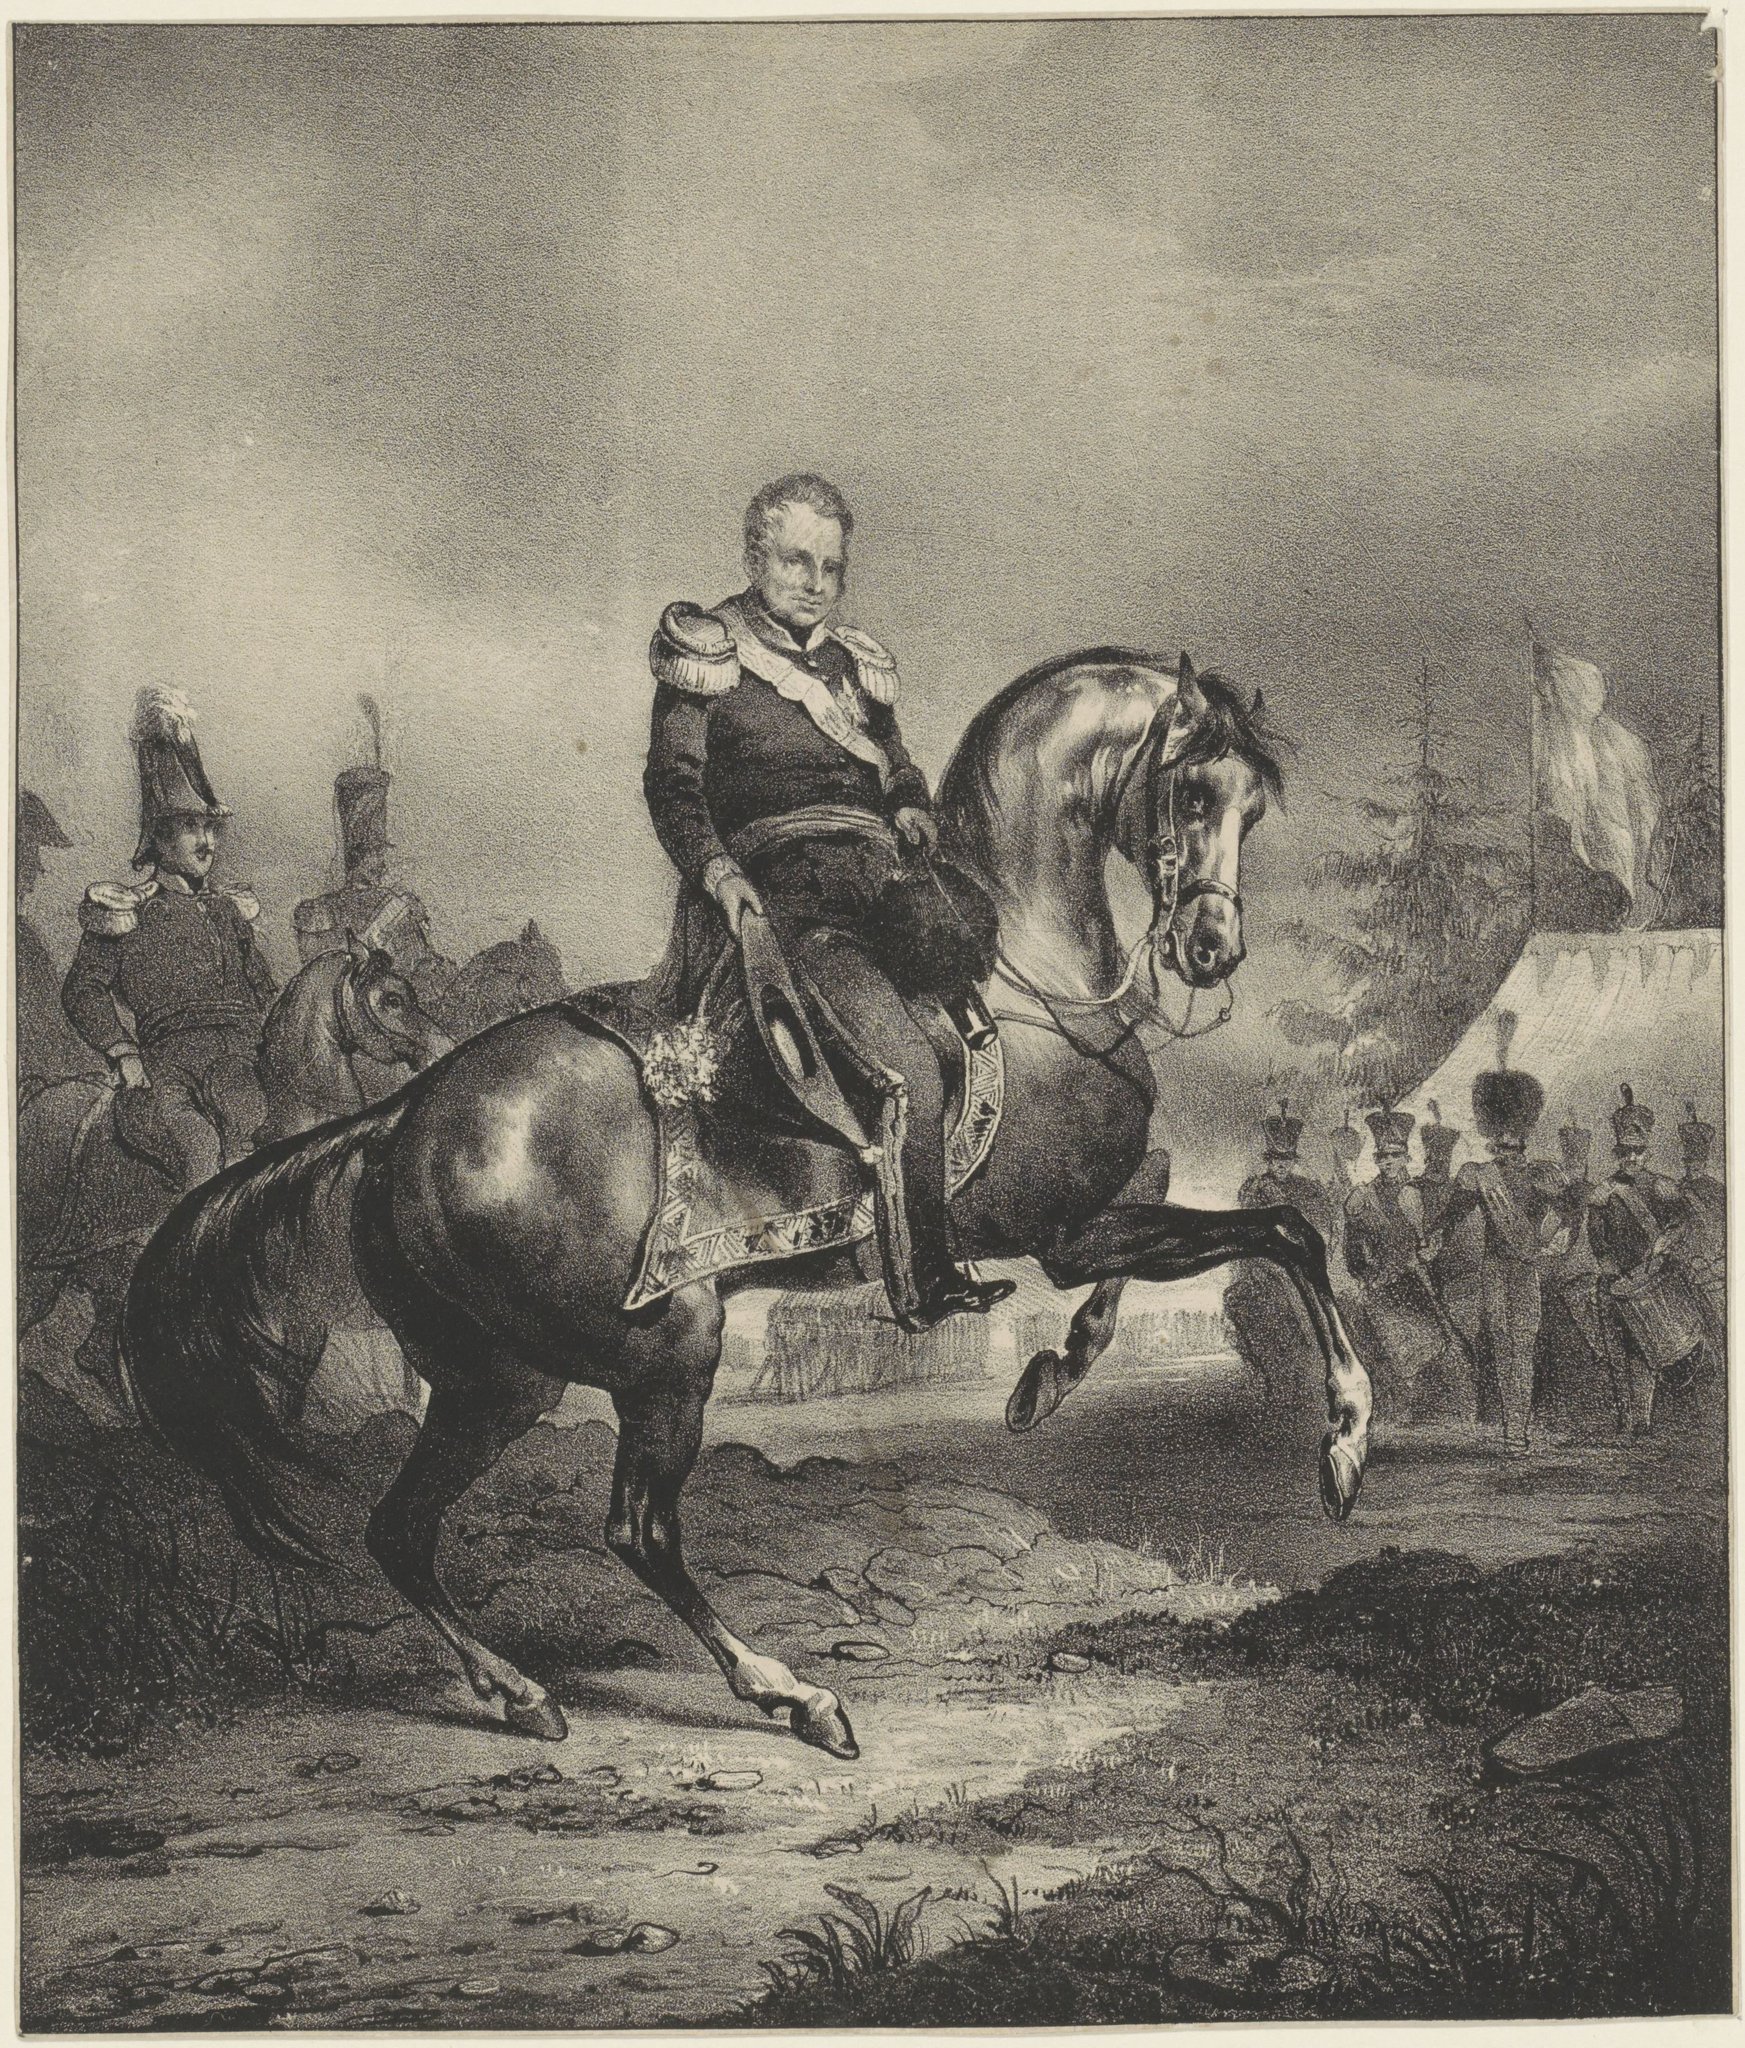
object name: print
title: Ruiterportret van Willem I Frederik, koning der Nederlanden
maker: Anonymous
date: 1815-1899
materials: paper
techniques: lithograph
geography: netherlands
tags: berlin, william i of the netherlands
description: De hier vermelde titel verwijst naar de hoogst verkregen titel van de geportretteerde, niet per se naar de titel die de geportretteerde op deze voorstelling draagt.